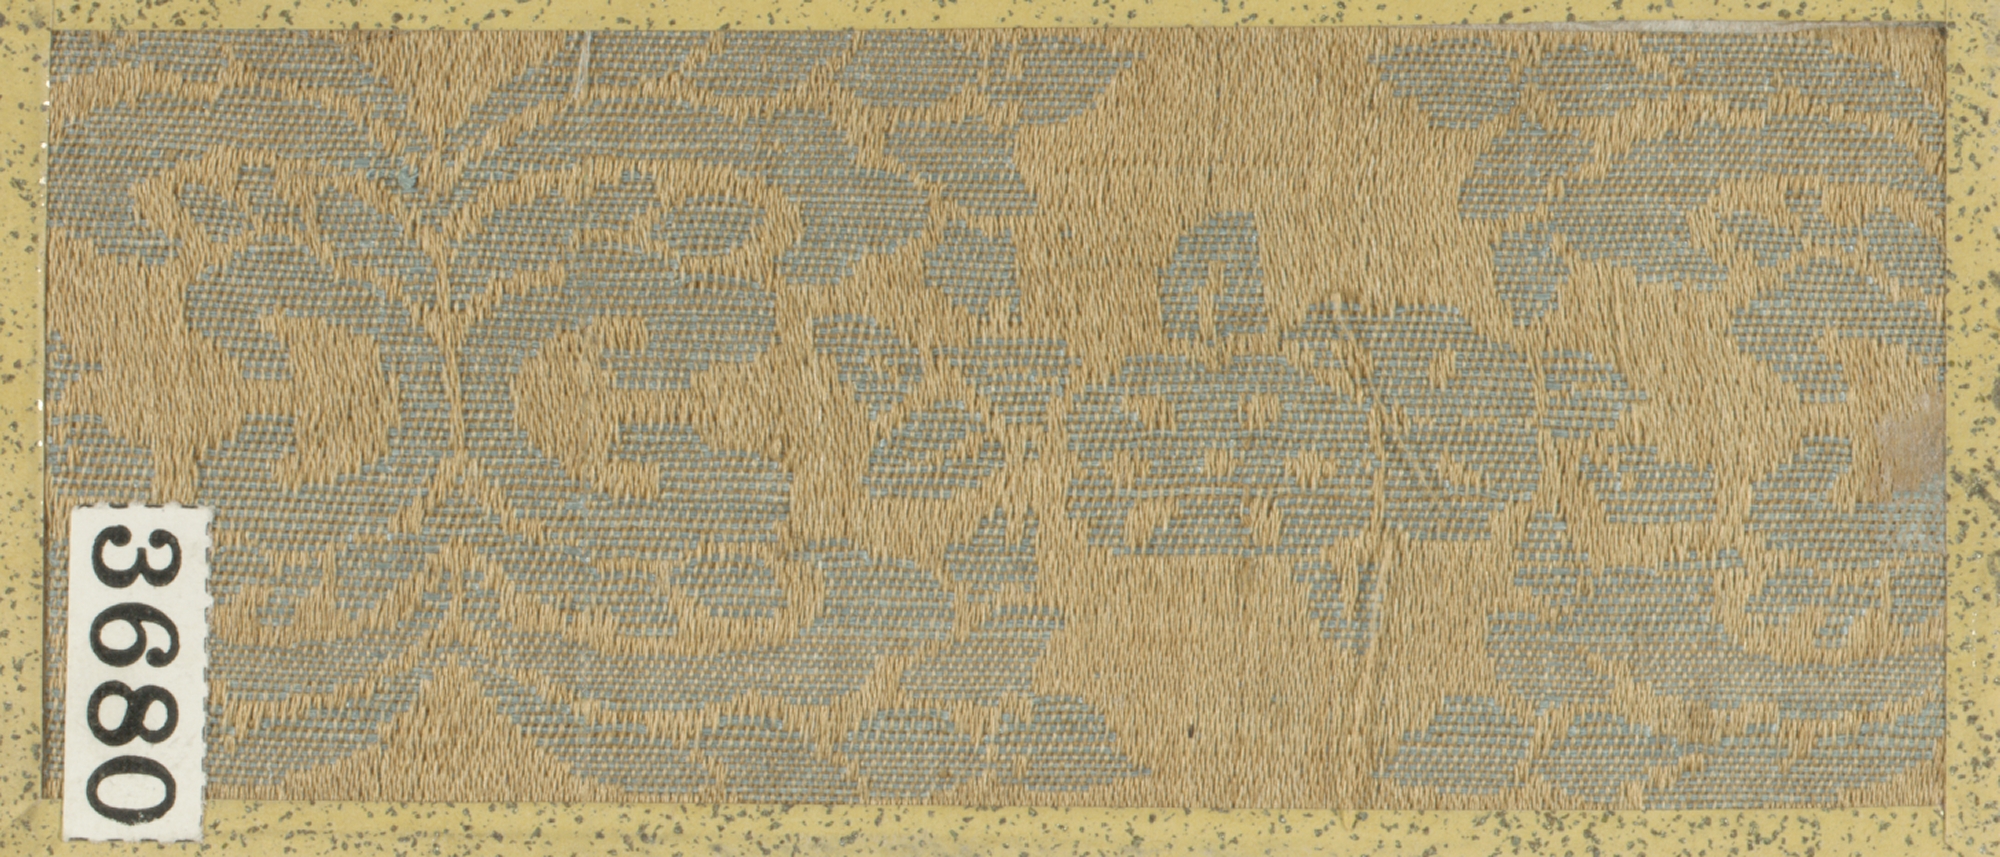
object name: sample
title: Textile Sample from Sample Book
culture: japanese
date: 1801-1900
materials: silk